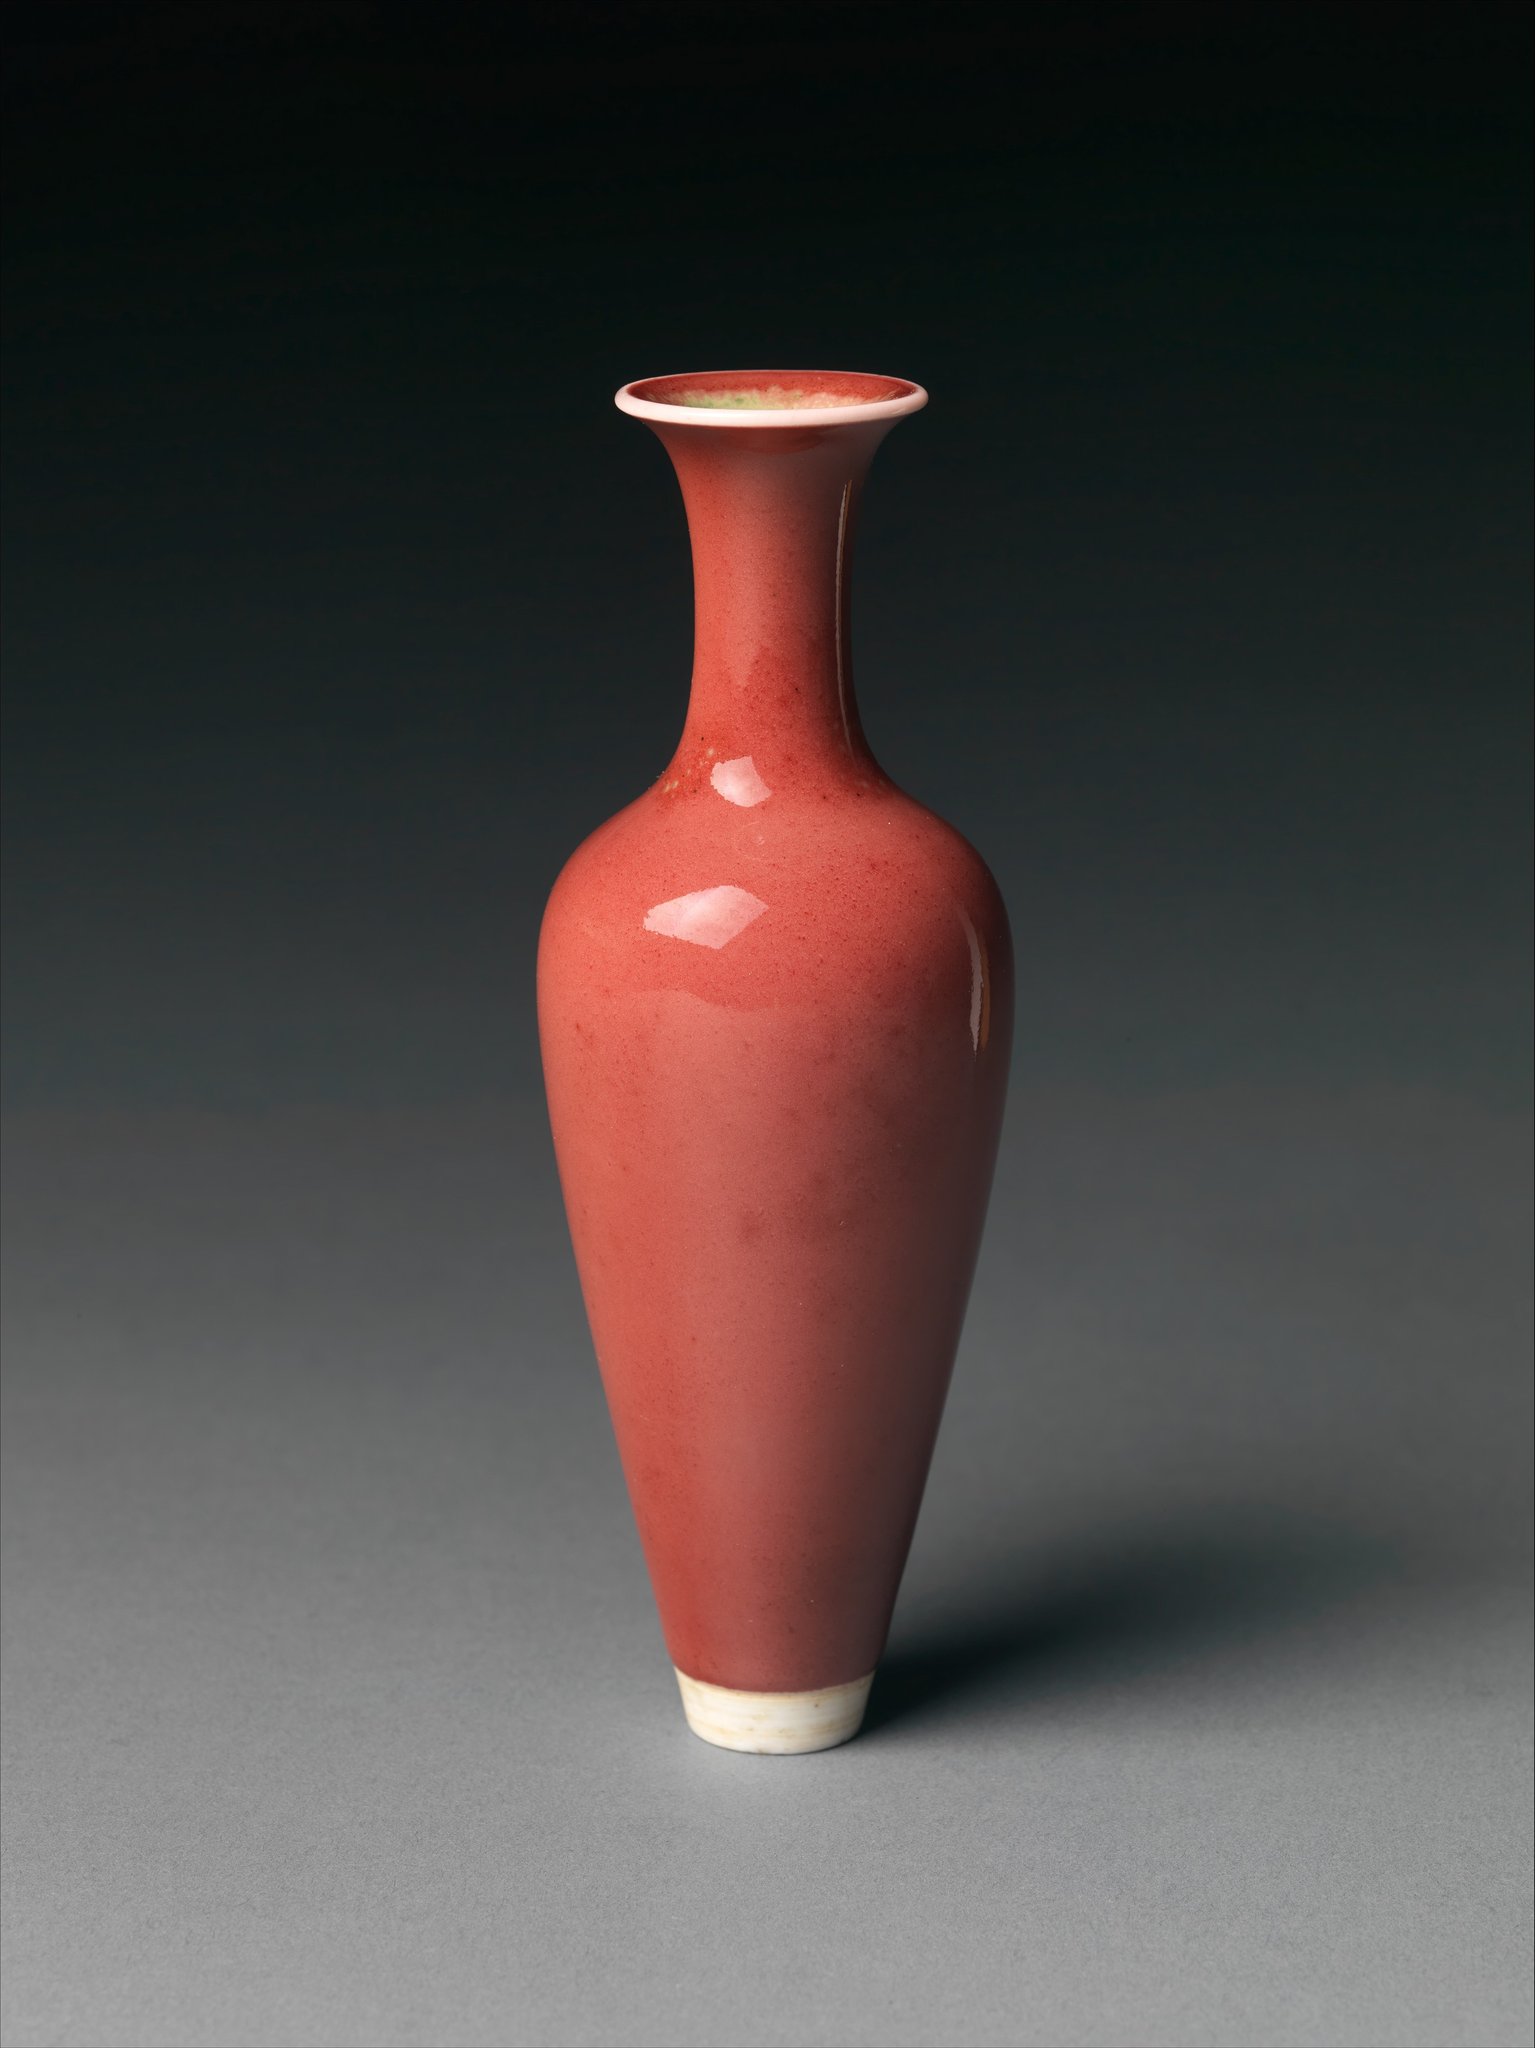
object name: vase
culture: chinese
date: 1667-1733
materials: glaze, porcelain, silver